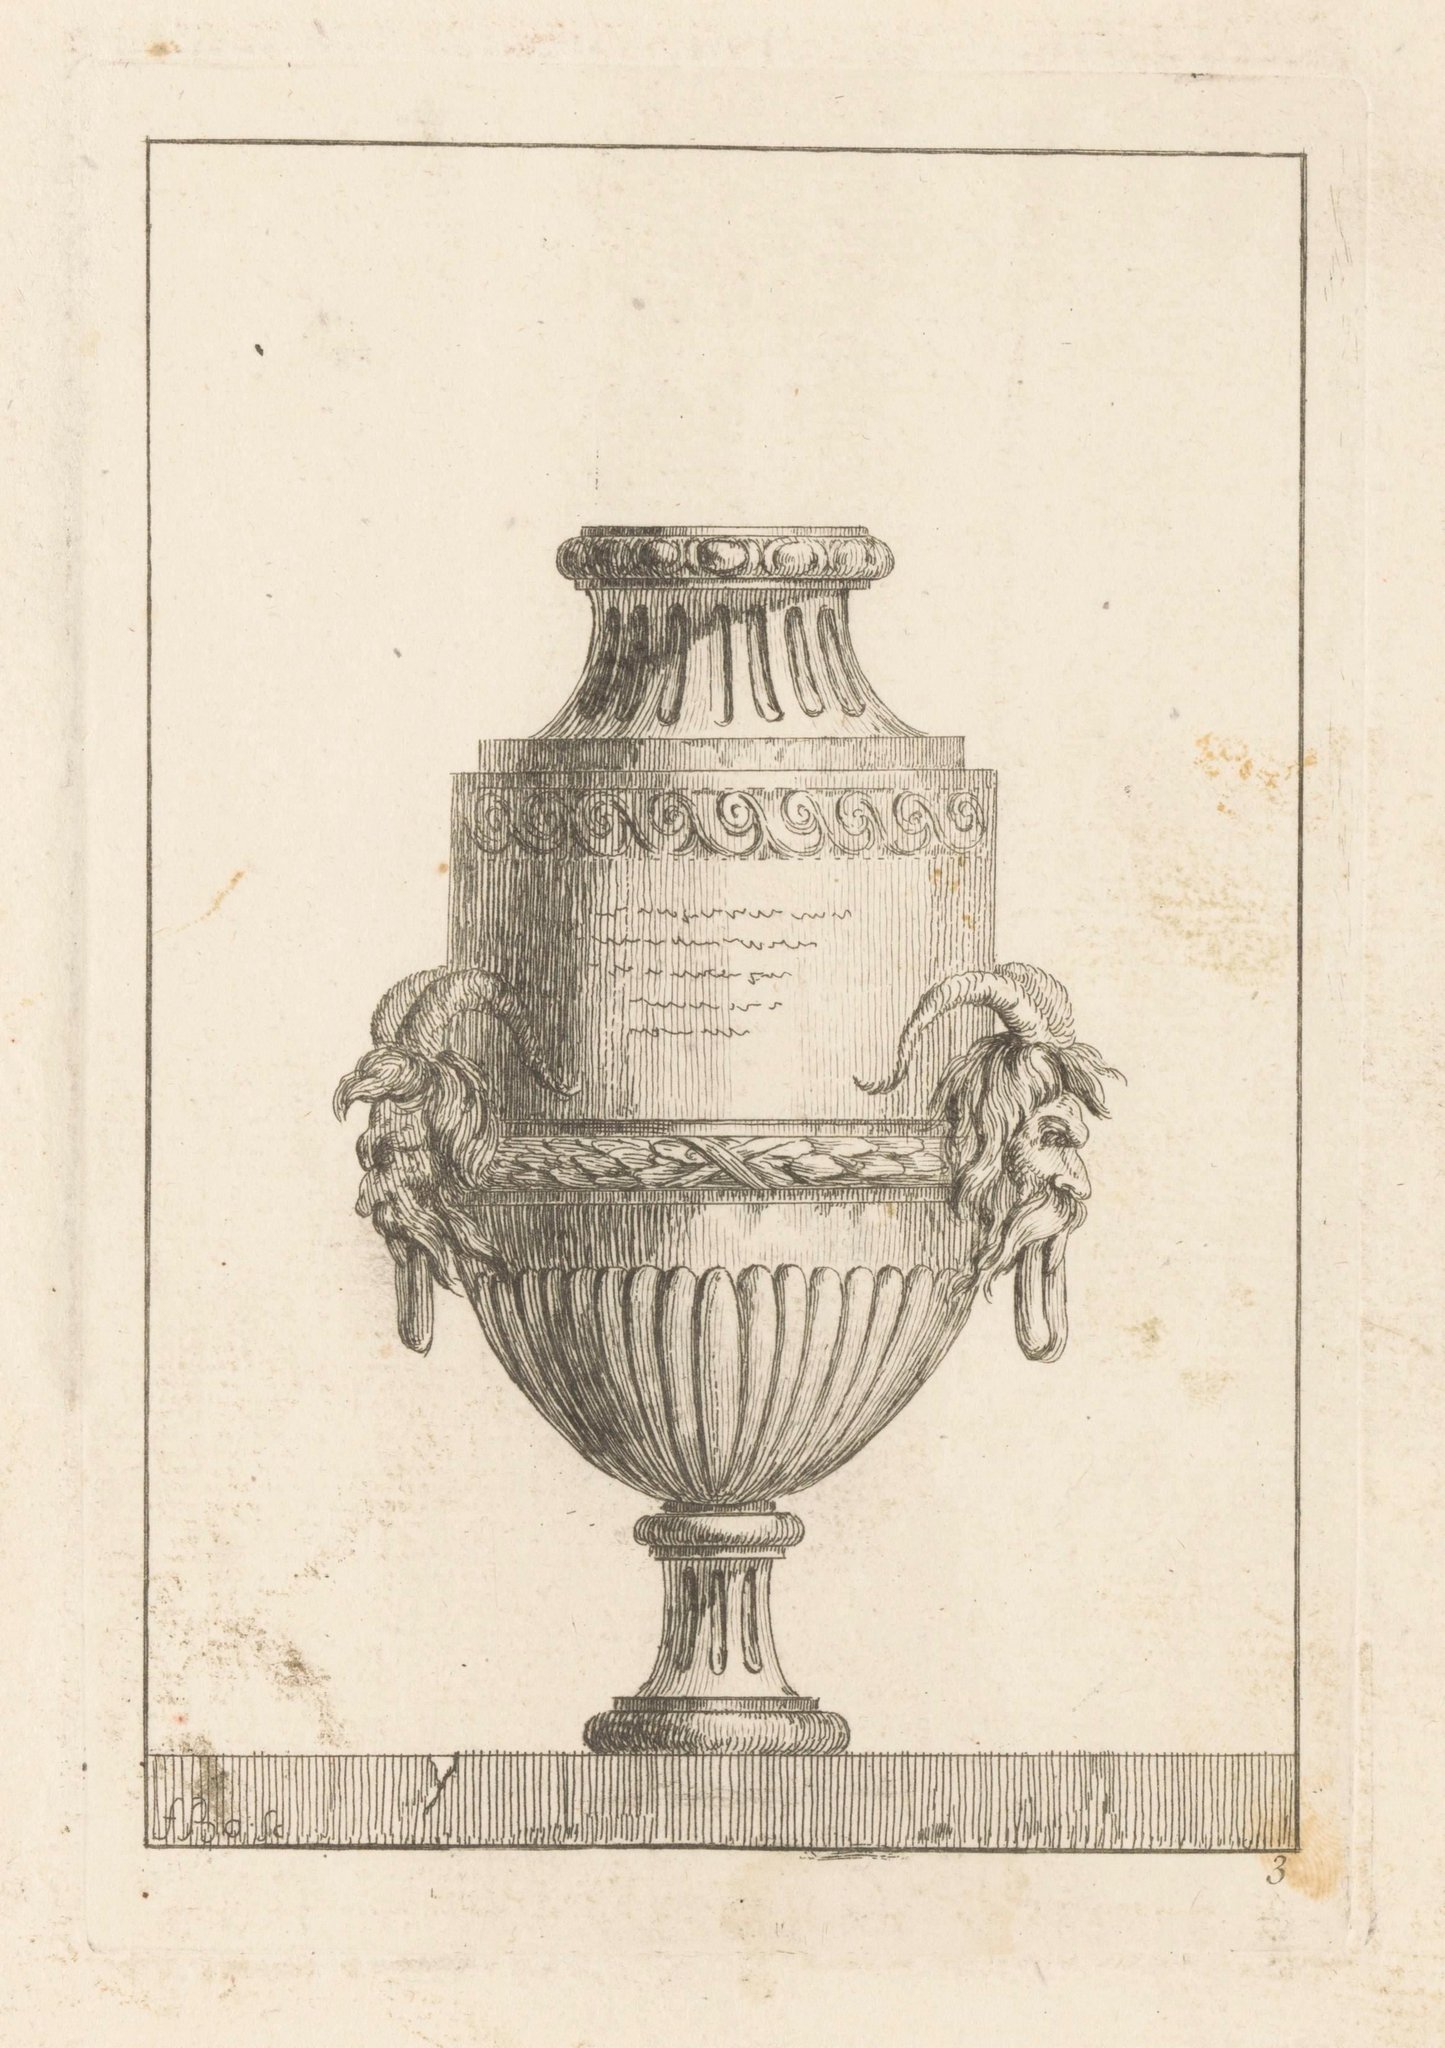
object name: ornament print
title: Nouveau Livre de Vases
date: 1755-1782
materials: paper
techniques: etching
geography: paris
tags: vase ~ ornament, satyr(s) (in general)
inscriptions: collector's mark: Lugt 2228